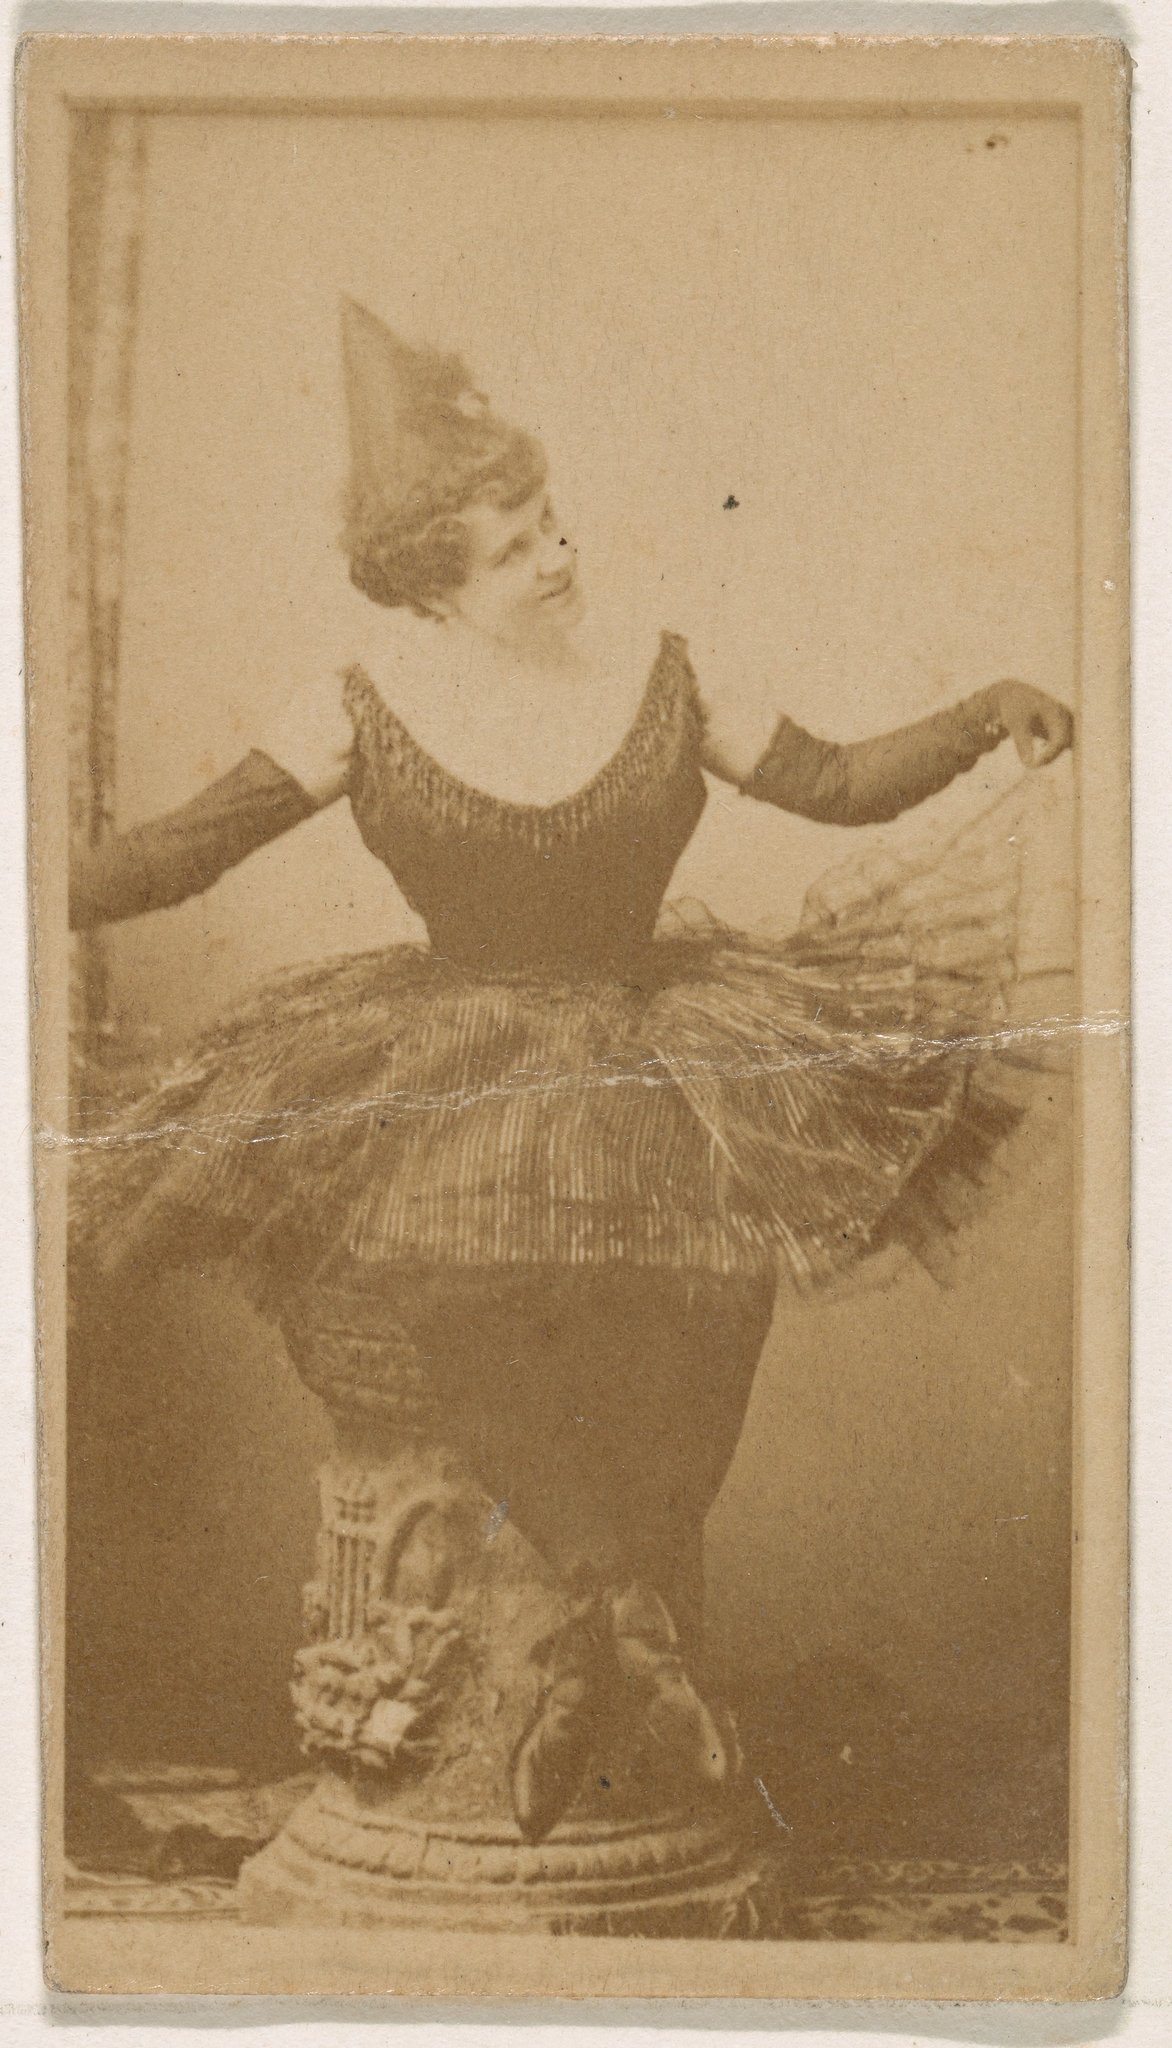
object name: photograph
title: Seated dancer holding skirt, from the Actresses series (N245) issued by Kinney Brothers to promote Sweet Caporal Cigarettes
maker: kinney brothers tobacco company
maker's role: publisher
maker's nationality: american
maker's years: 1869-2011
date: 1890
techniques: albumen silver print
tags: portraits,women,actresses